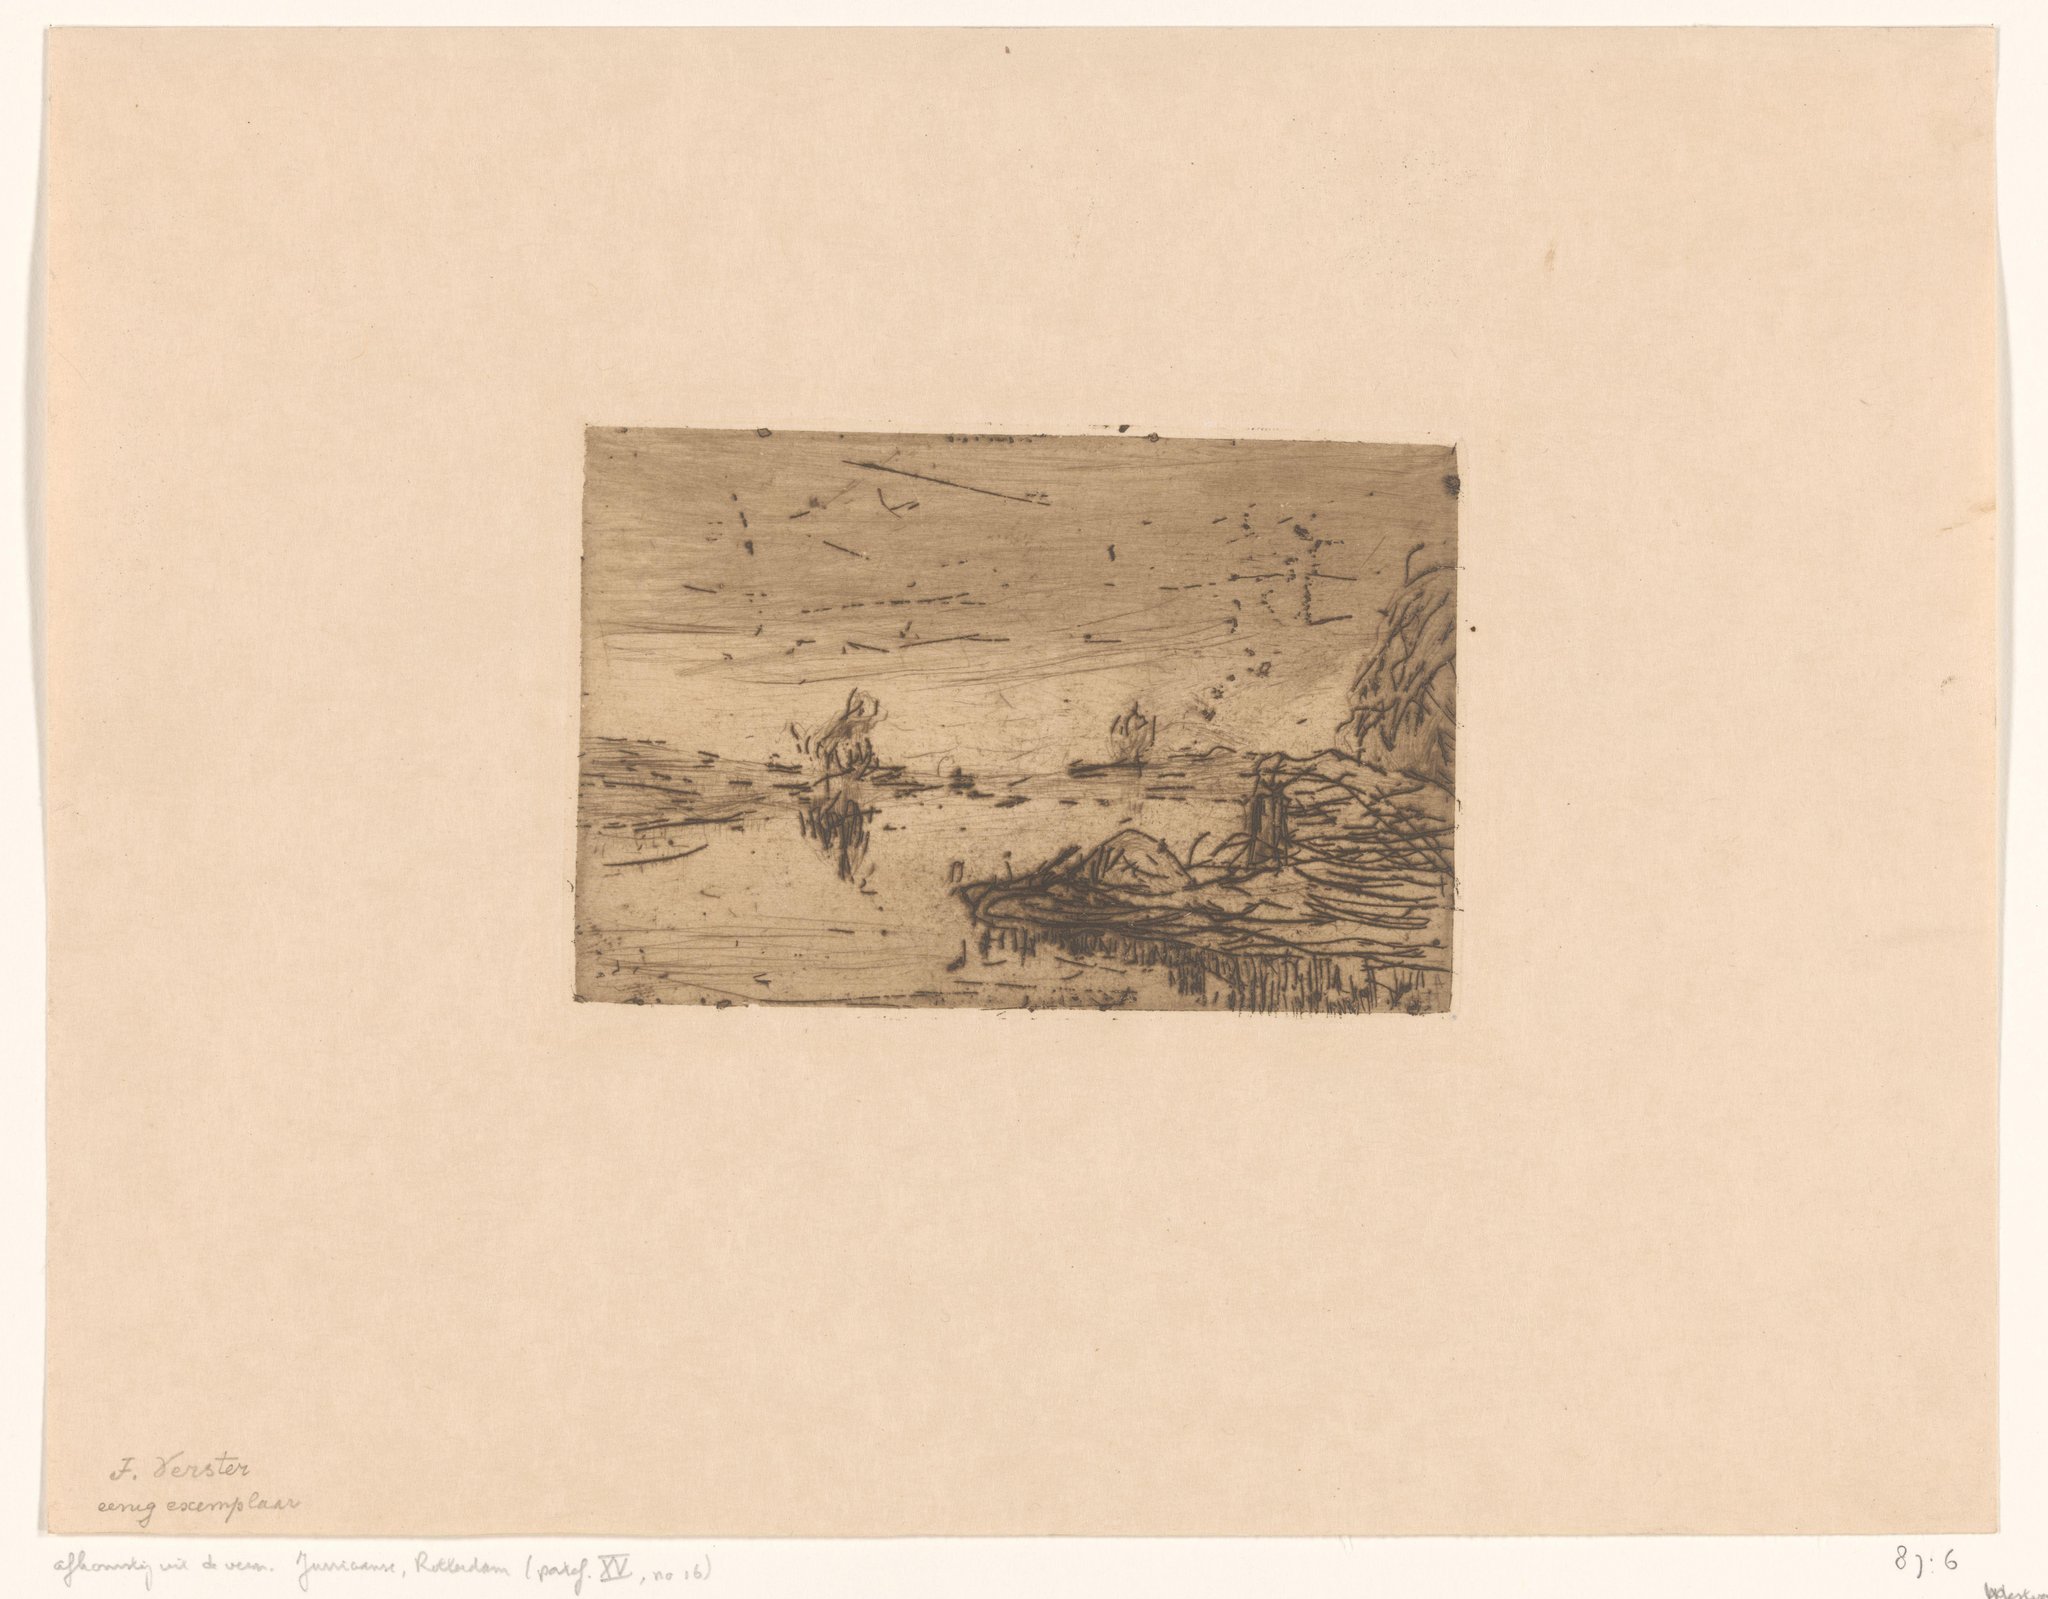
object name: print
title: Landschap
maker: floris verster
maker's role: draughtsman, painter, print maker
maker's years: 1861-1927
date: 1890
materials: paper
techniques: drypoint, etching, intaglio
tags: landscapes in the temperate zone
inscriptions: collector's mark: Lugt 2760, collector's mark: Lugt 2228